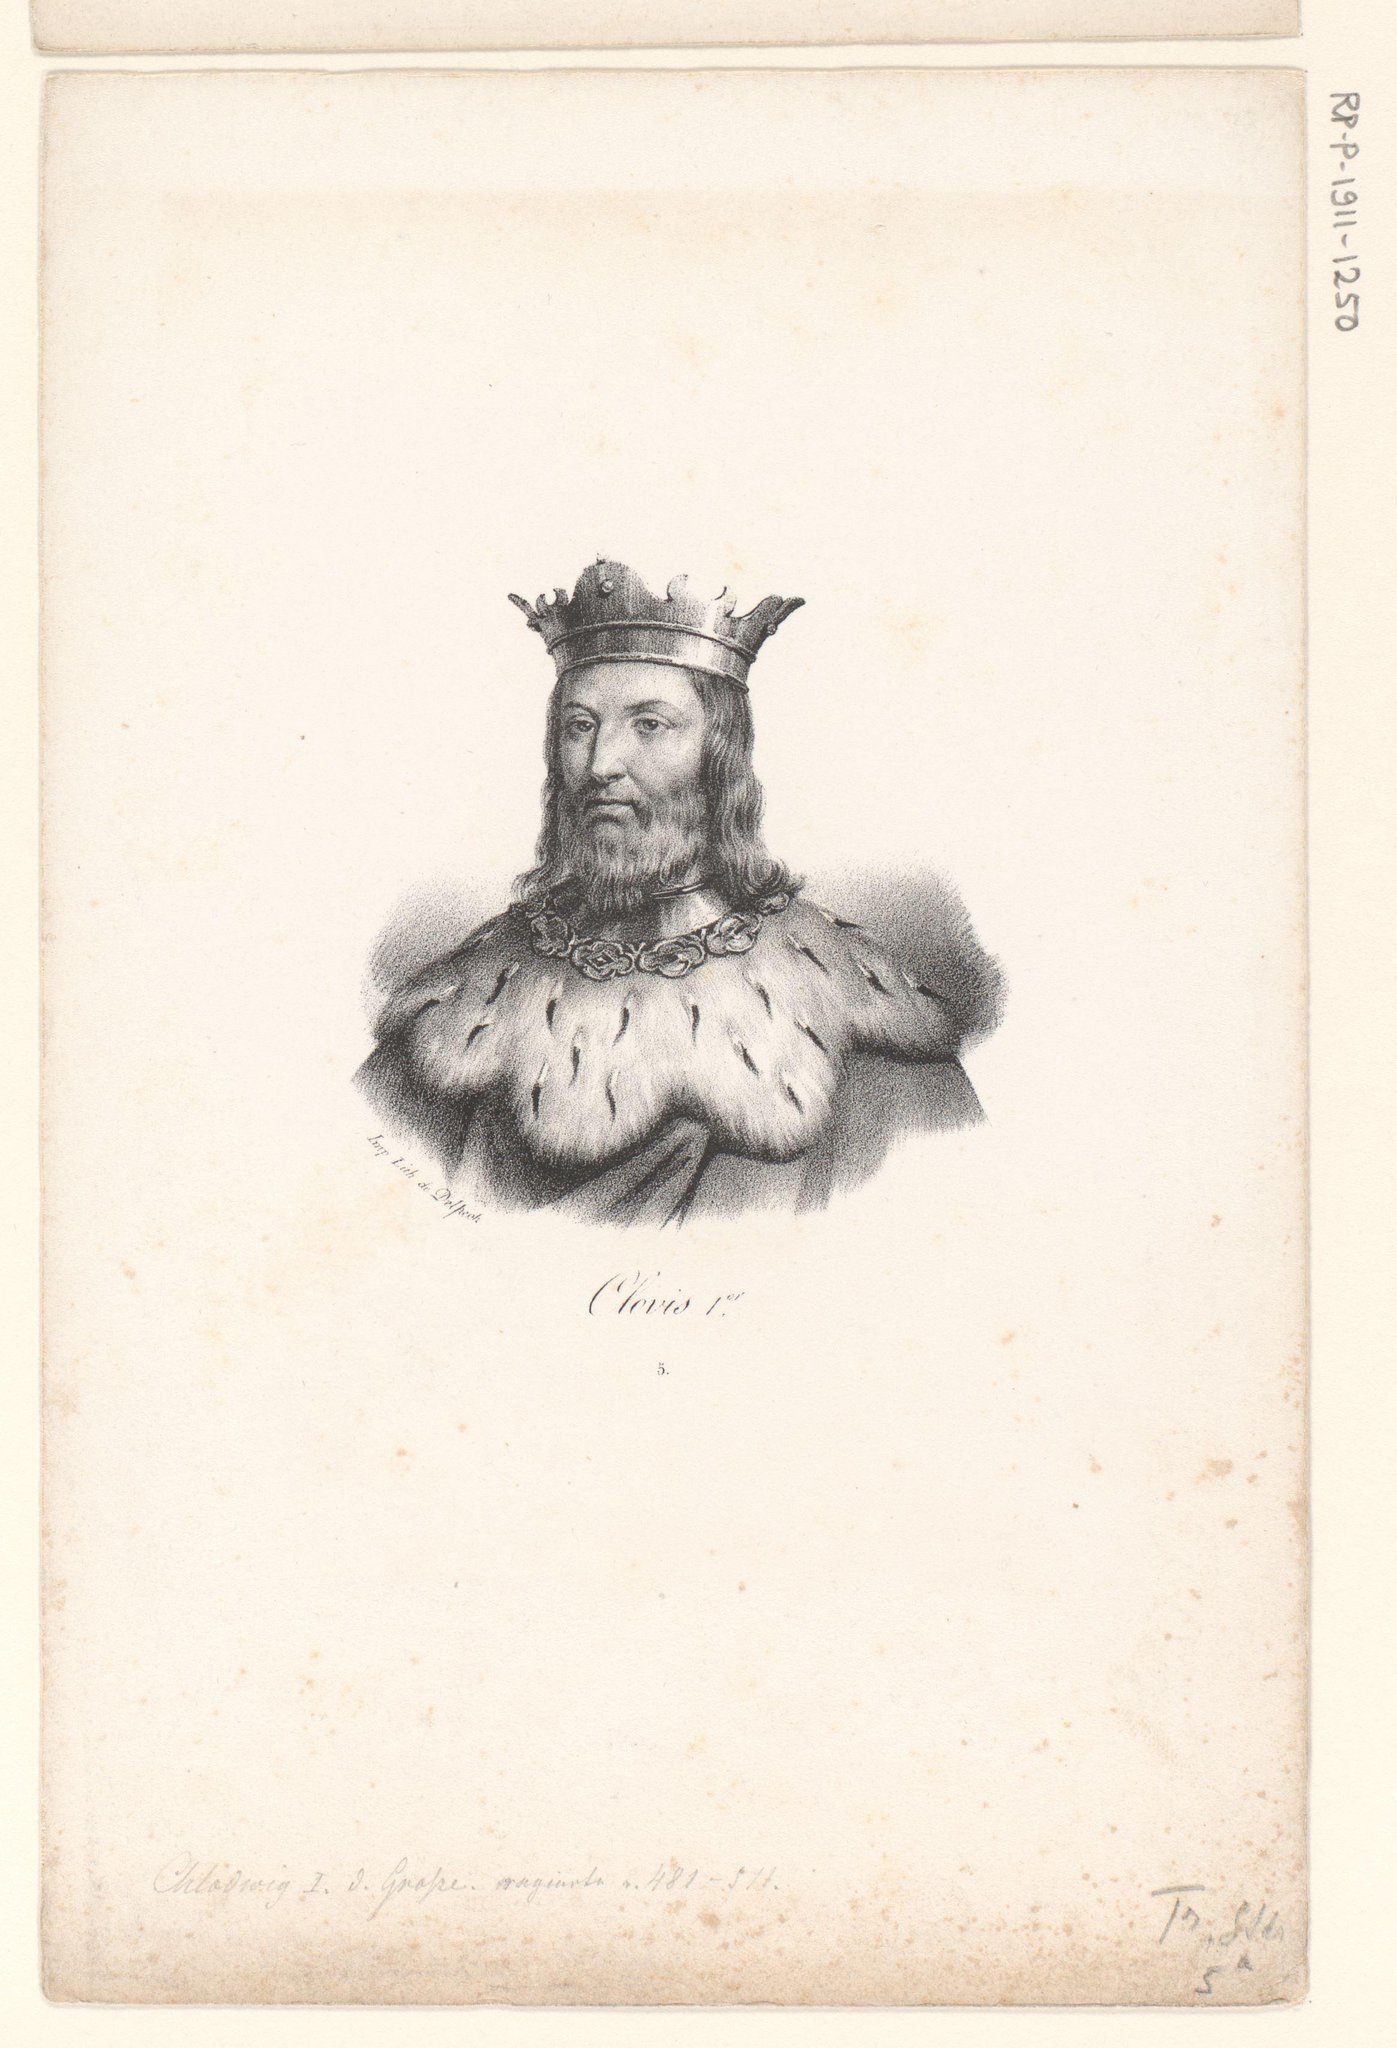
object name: print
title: Clovis 1er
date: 1818-1842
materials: paper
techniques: lithograph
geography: paris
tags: historical persons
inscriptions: collector's mark: Lugt 2228a